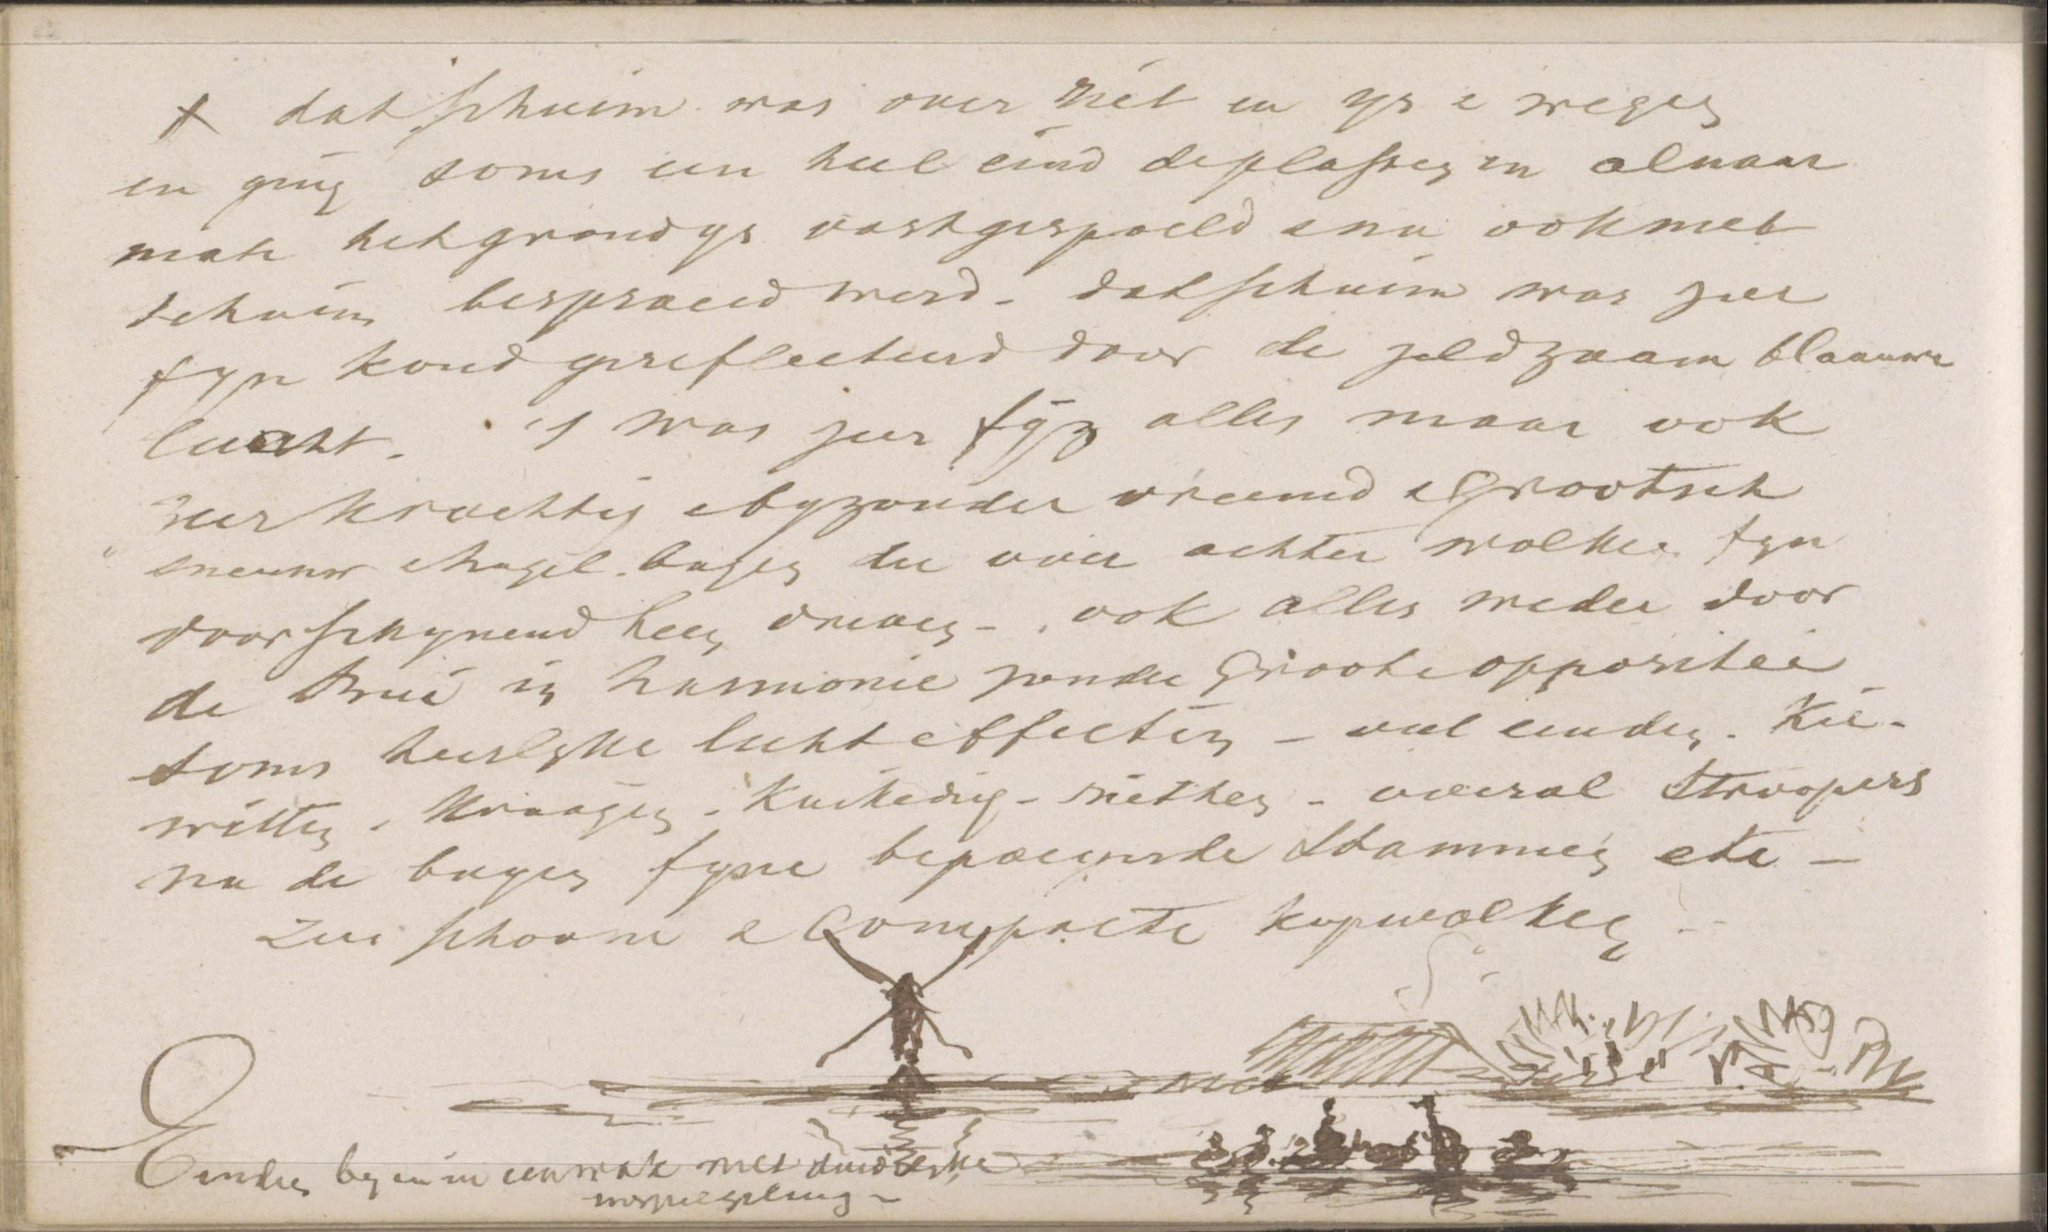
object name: sketchbook leaf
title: Rivierlandschap met eenden in en bij een wak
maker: johannes tavenraat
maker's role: draughtsman, painter, print maker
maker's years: 1809-1881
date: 1864-1880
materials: ink, paper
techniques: pen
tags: river, windmill in landscape, water-birds: duck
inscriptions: annotation: ‘[...]’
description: Op de achtergrond een molen. Blad 61 verso uit een schetsboek met 98 bladen.